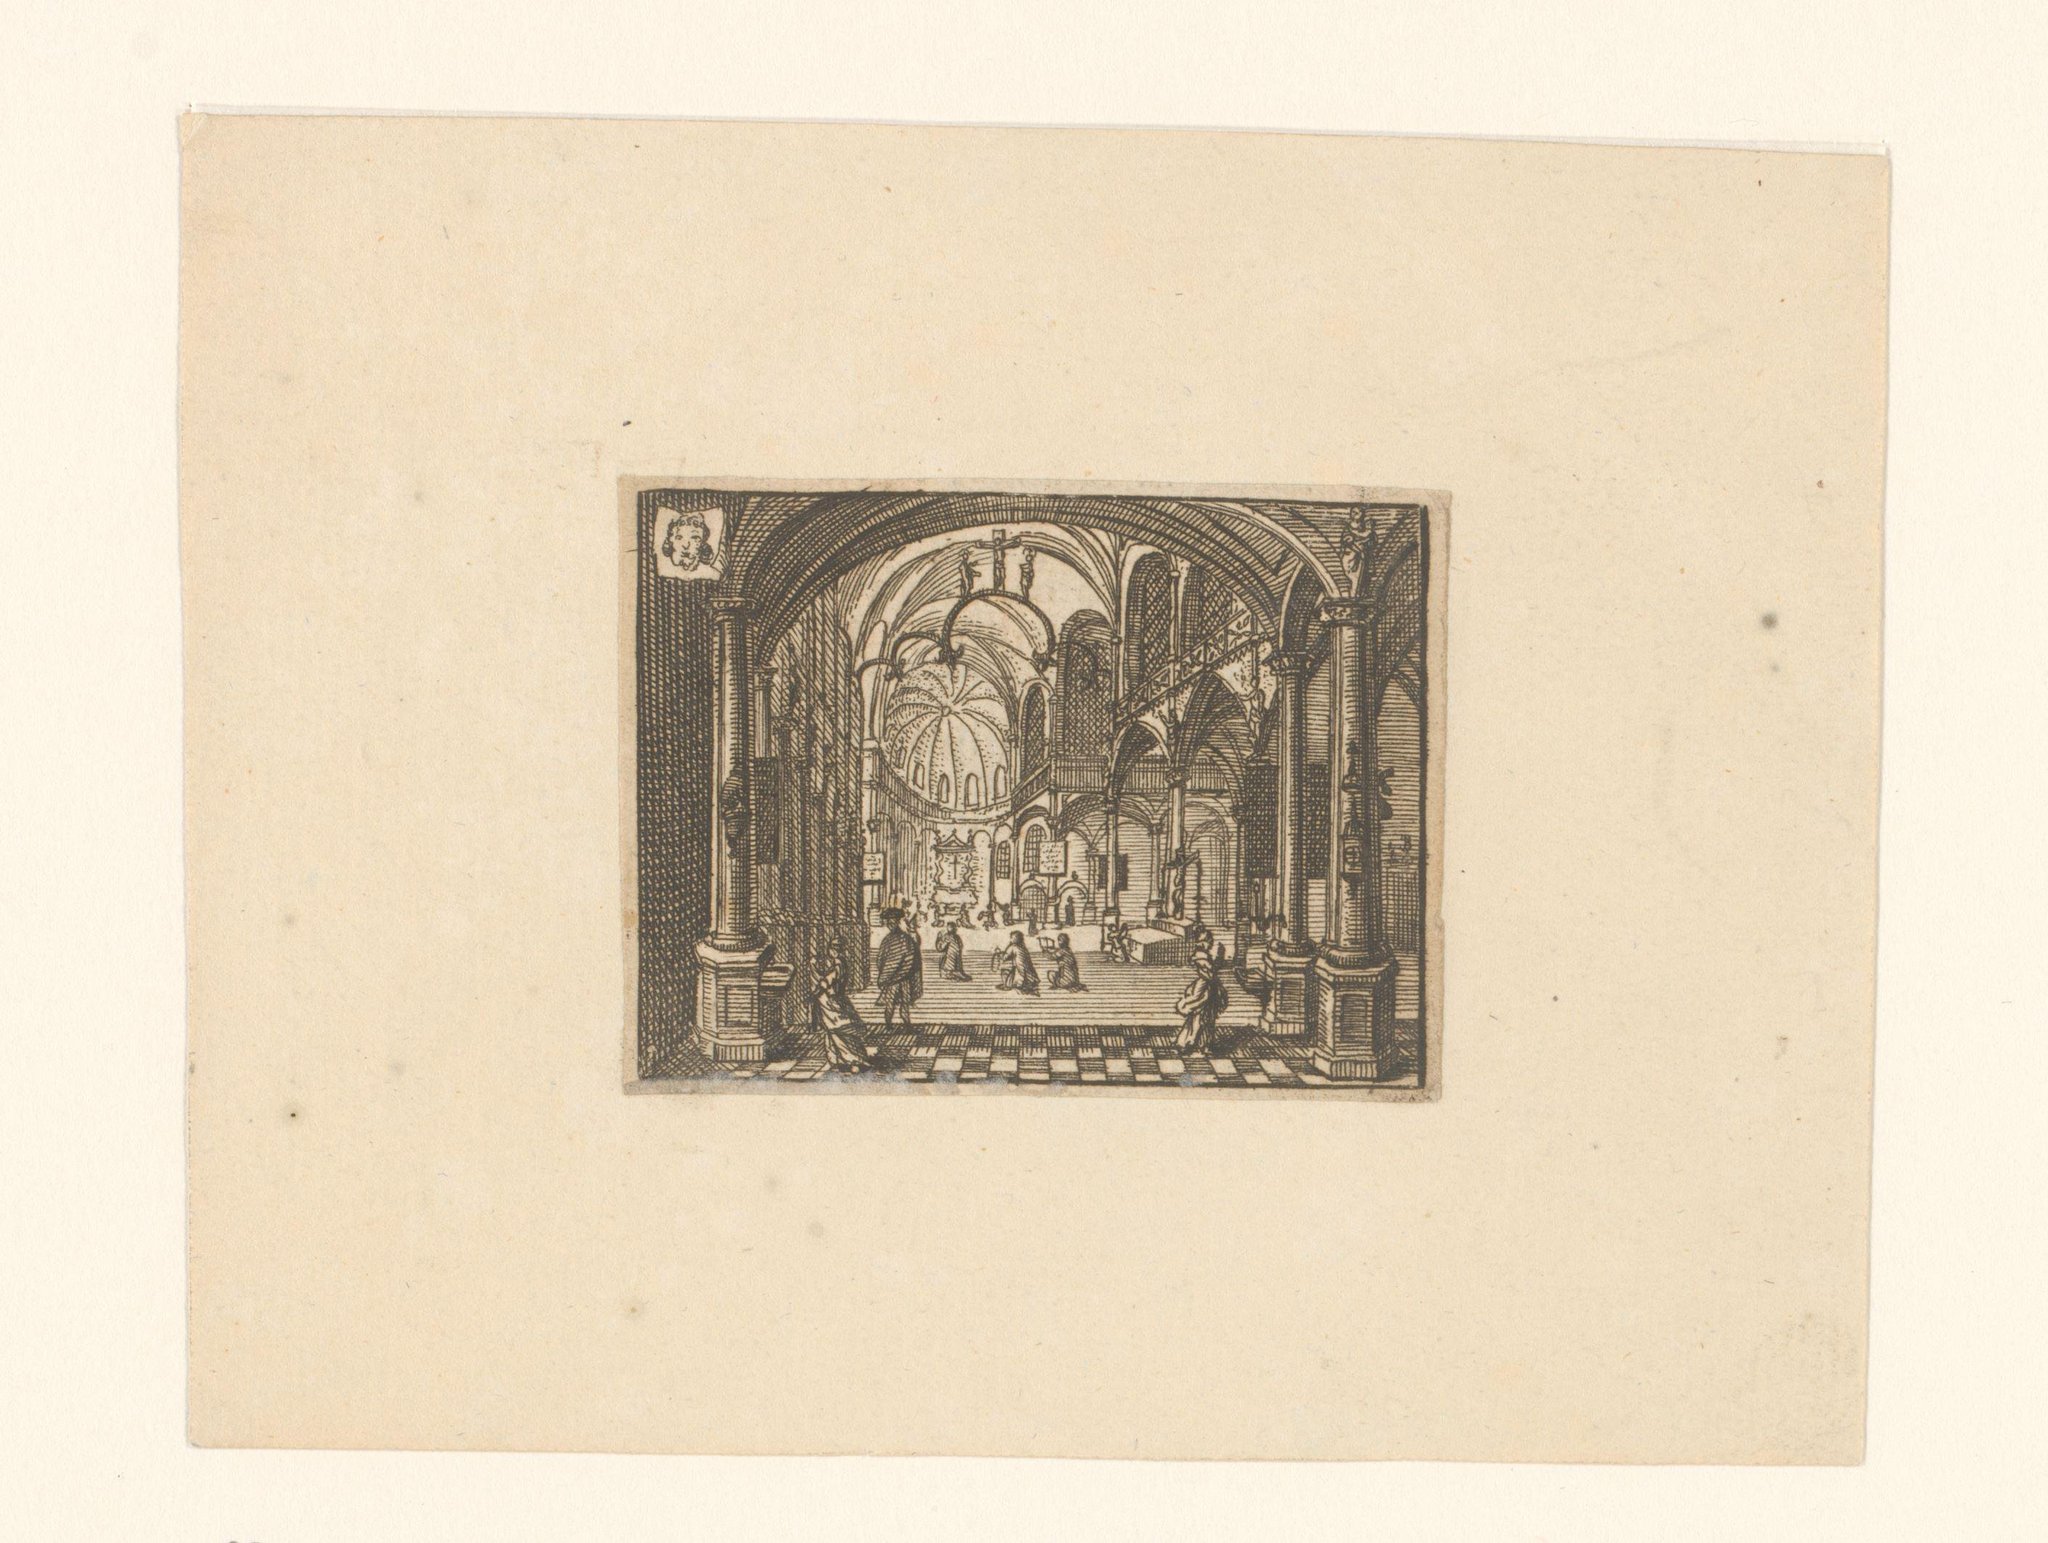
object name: print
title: Interieur van een kerk, mogelijk de Sint-Pietersbasiliek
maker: Anonymous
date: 1700-1799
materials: paper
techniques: etching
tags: interior of church, 'vera icon', 'sudarium', veronica-portrait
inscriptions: collector's mark: Lugt 2228